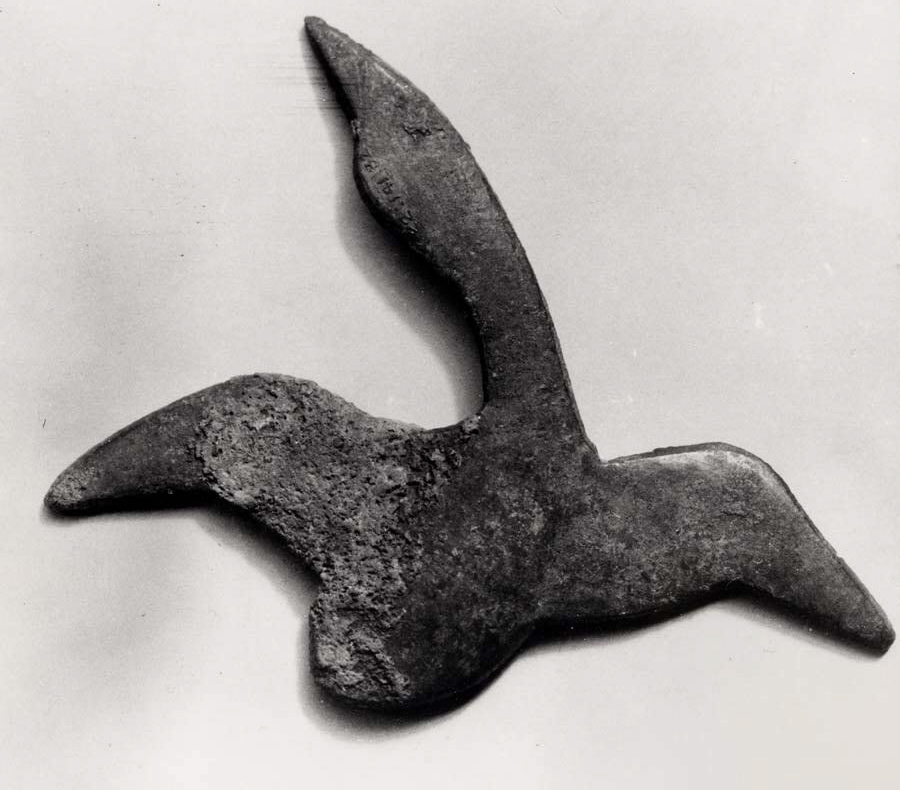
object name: ornament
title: Bird-Shaped Ornament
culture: korean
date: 918-1392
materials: bronze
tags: birds